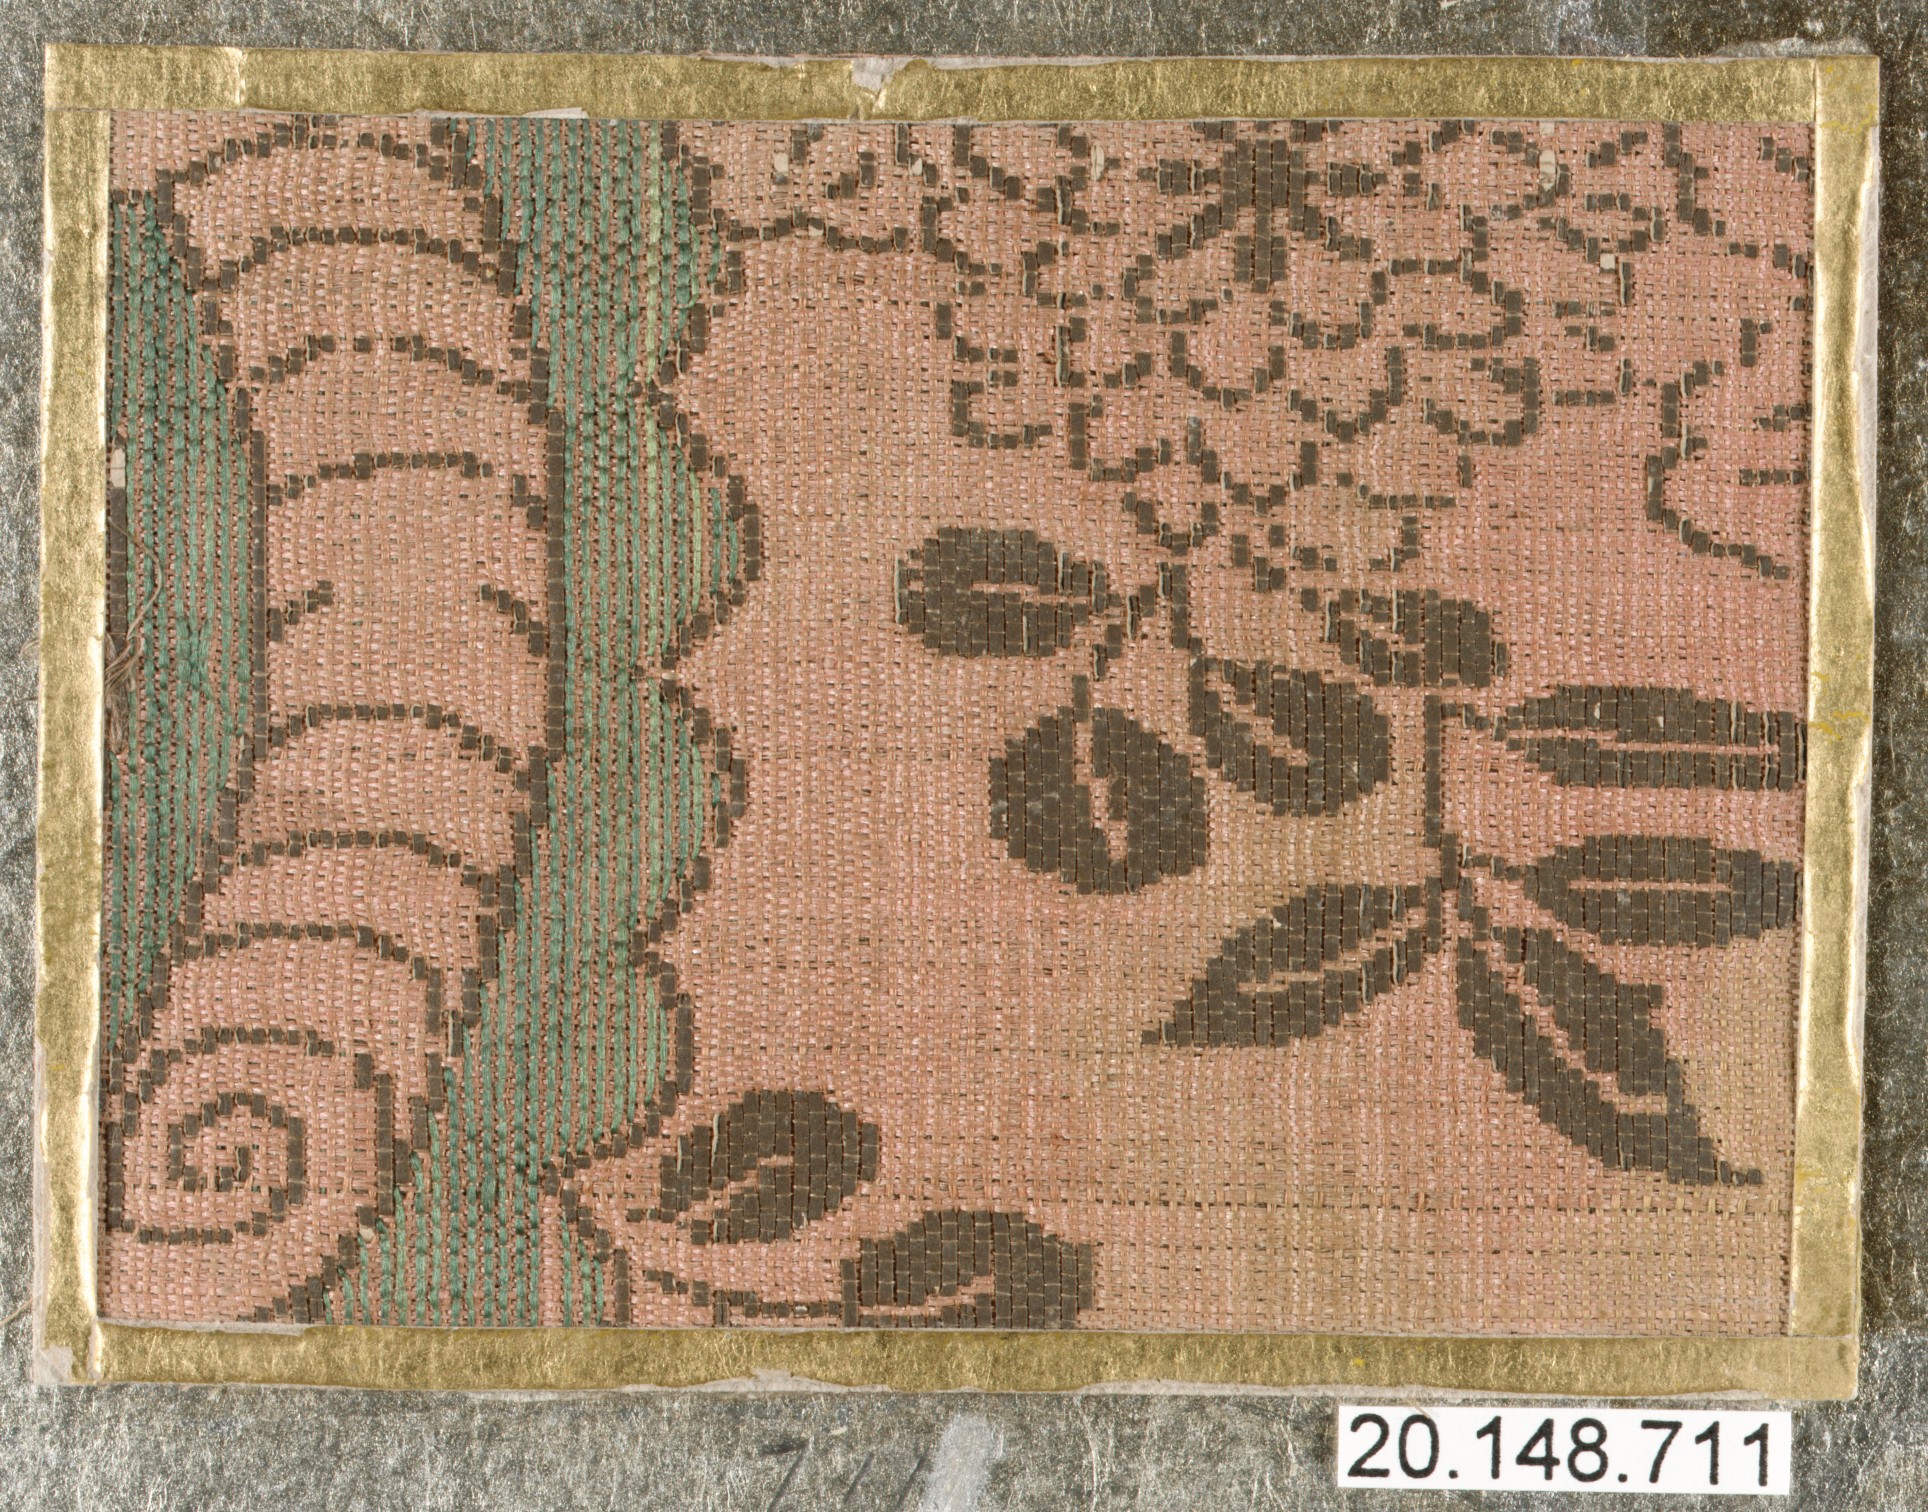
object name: piece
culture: japanese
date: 1801-1900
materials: silk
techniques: compound weave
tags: leaves